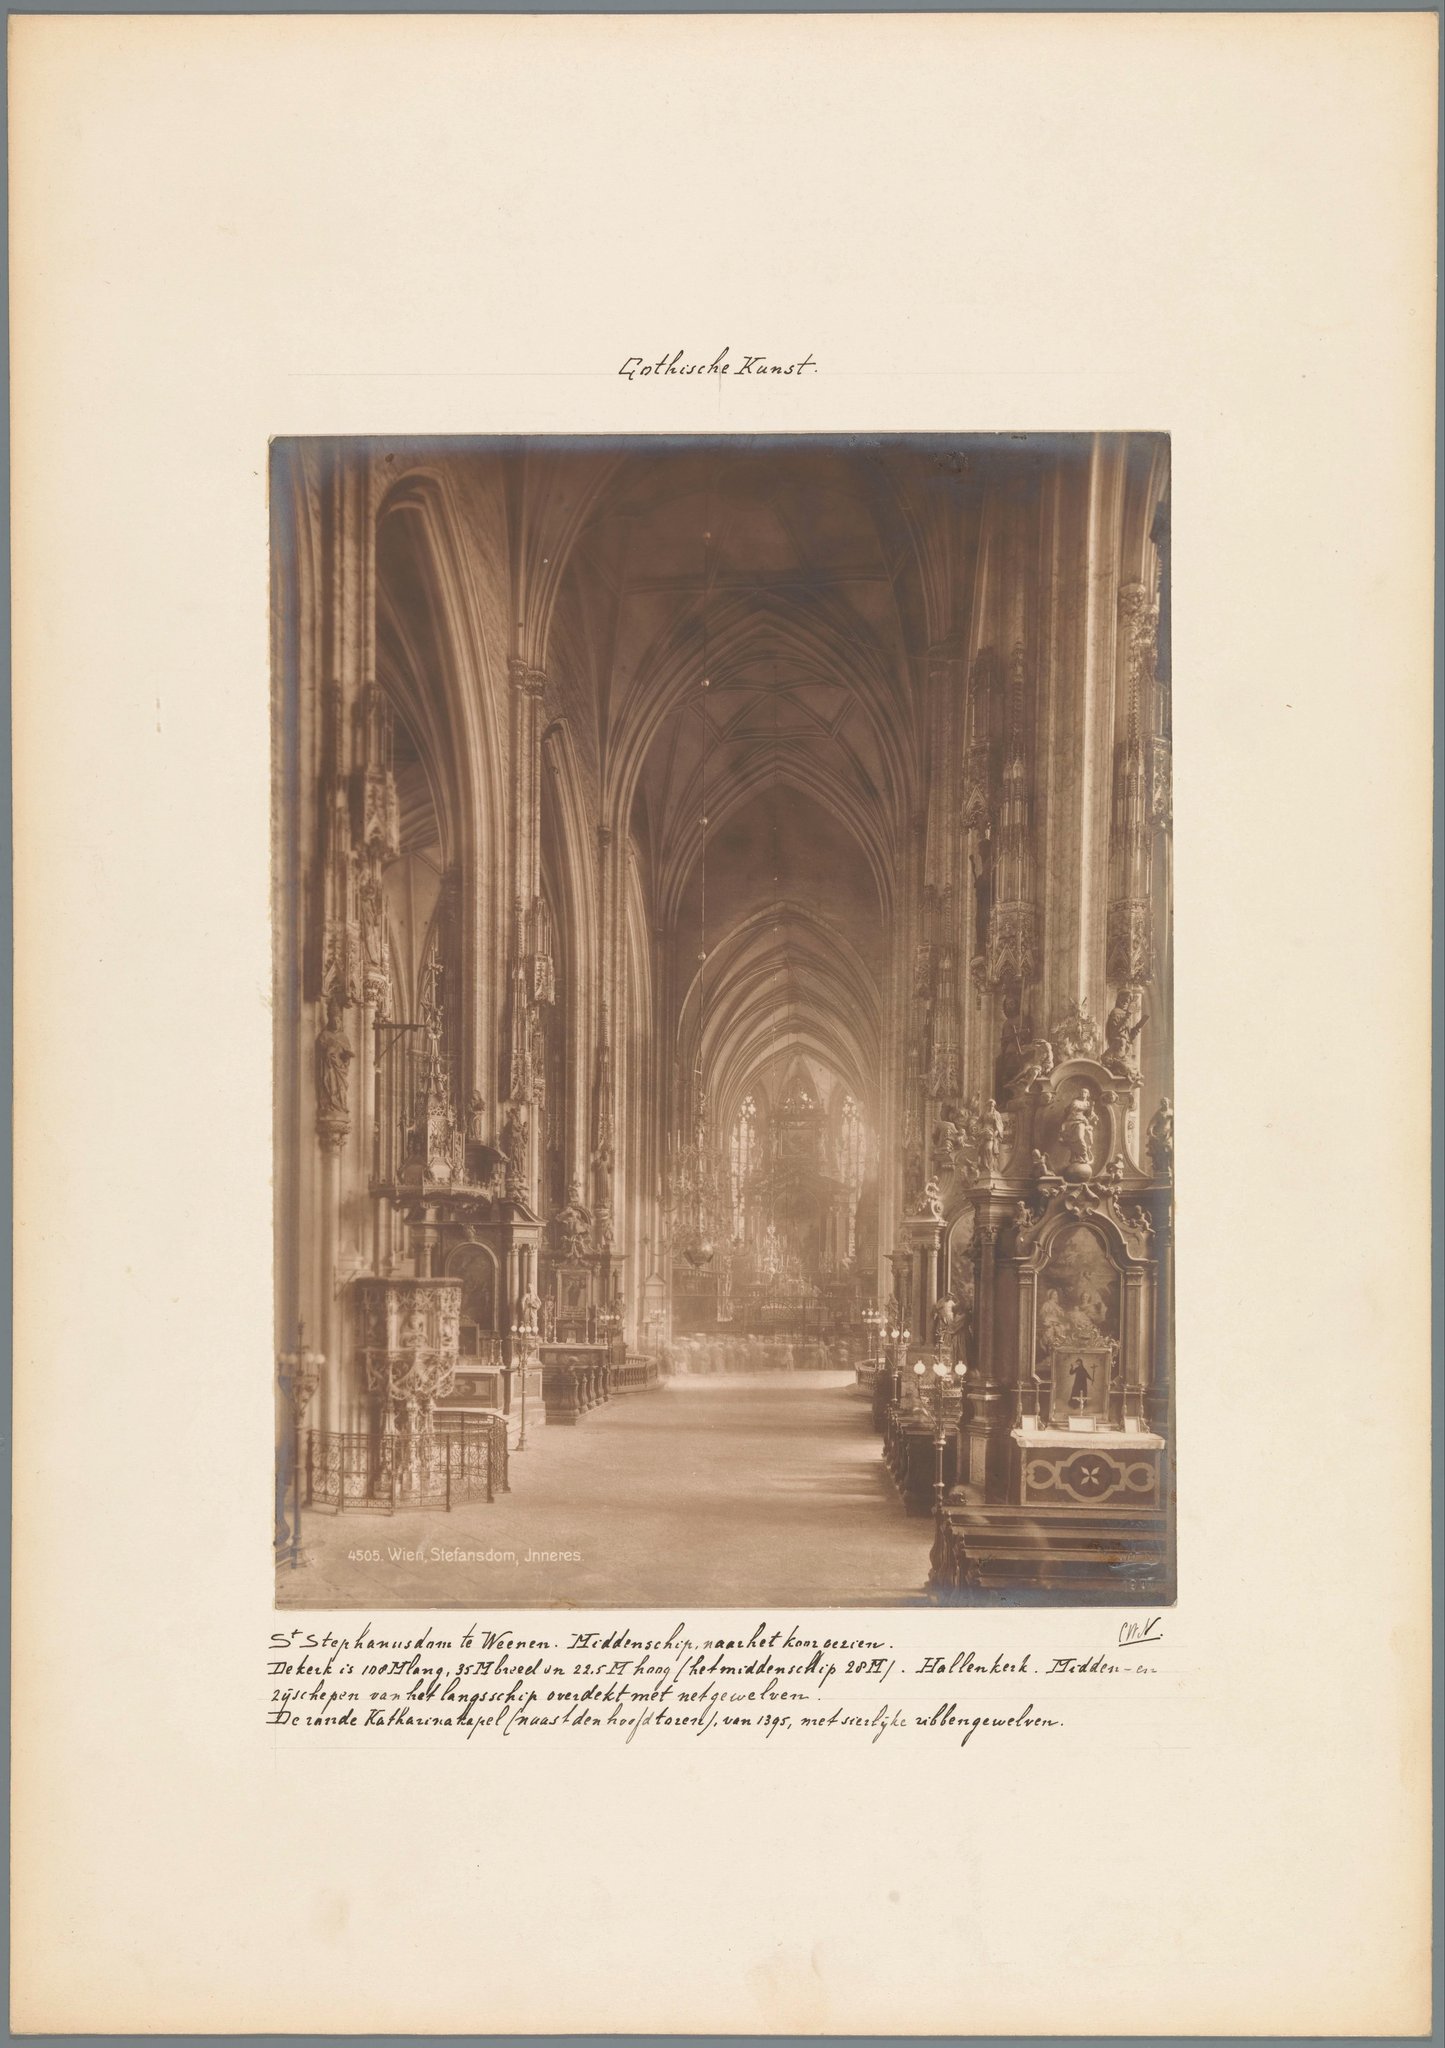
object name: photograph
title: Wien, Stefansdom, Unneres.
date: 1907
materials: cardboard, photographic support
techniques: daylight paper print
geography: stephansdom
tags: parts of church interior: nave, parts of church interior: choir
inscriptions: name: ‘WÜRTHLE & SOHN WIEN 1907’, inscription: ‘CWN.’, number: ‘4505.’, collector's mark: ‘INSTITUUT VOOR KUNST-NIJVERHEIDSONDERWIJS GABRIËL METSUSTRAAT No. 16 AMSTERDAM’, inscription: ‘Gothische Kunst.’, collector's mark: ‘KUNSTNIJVERHEIDSCHOOL QUELLINUS AMSTERDAM FRANS HALSSTRAAT 14.’